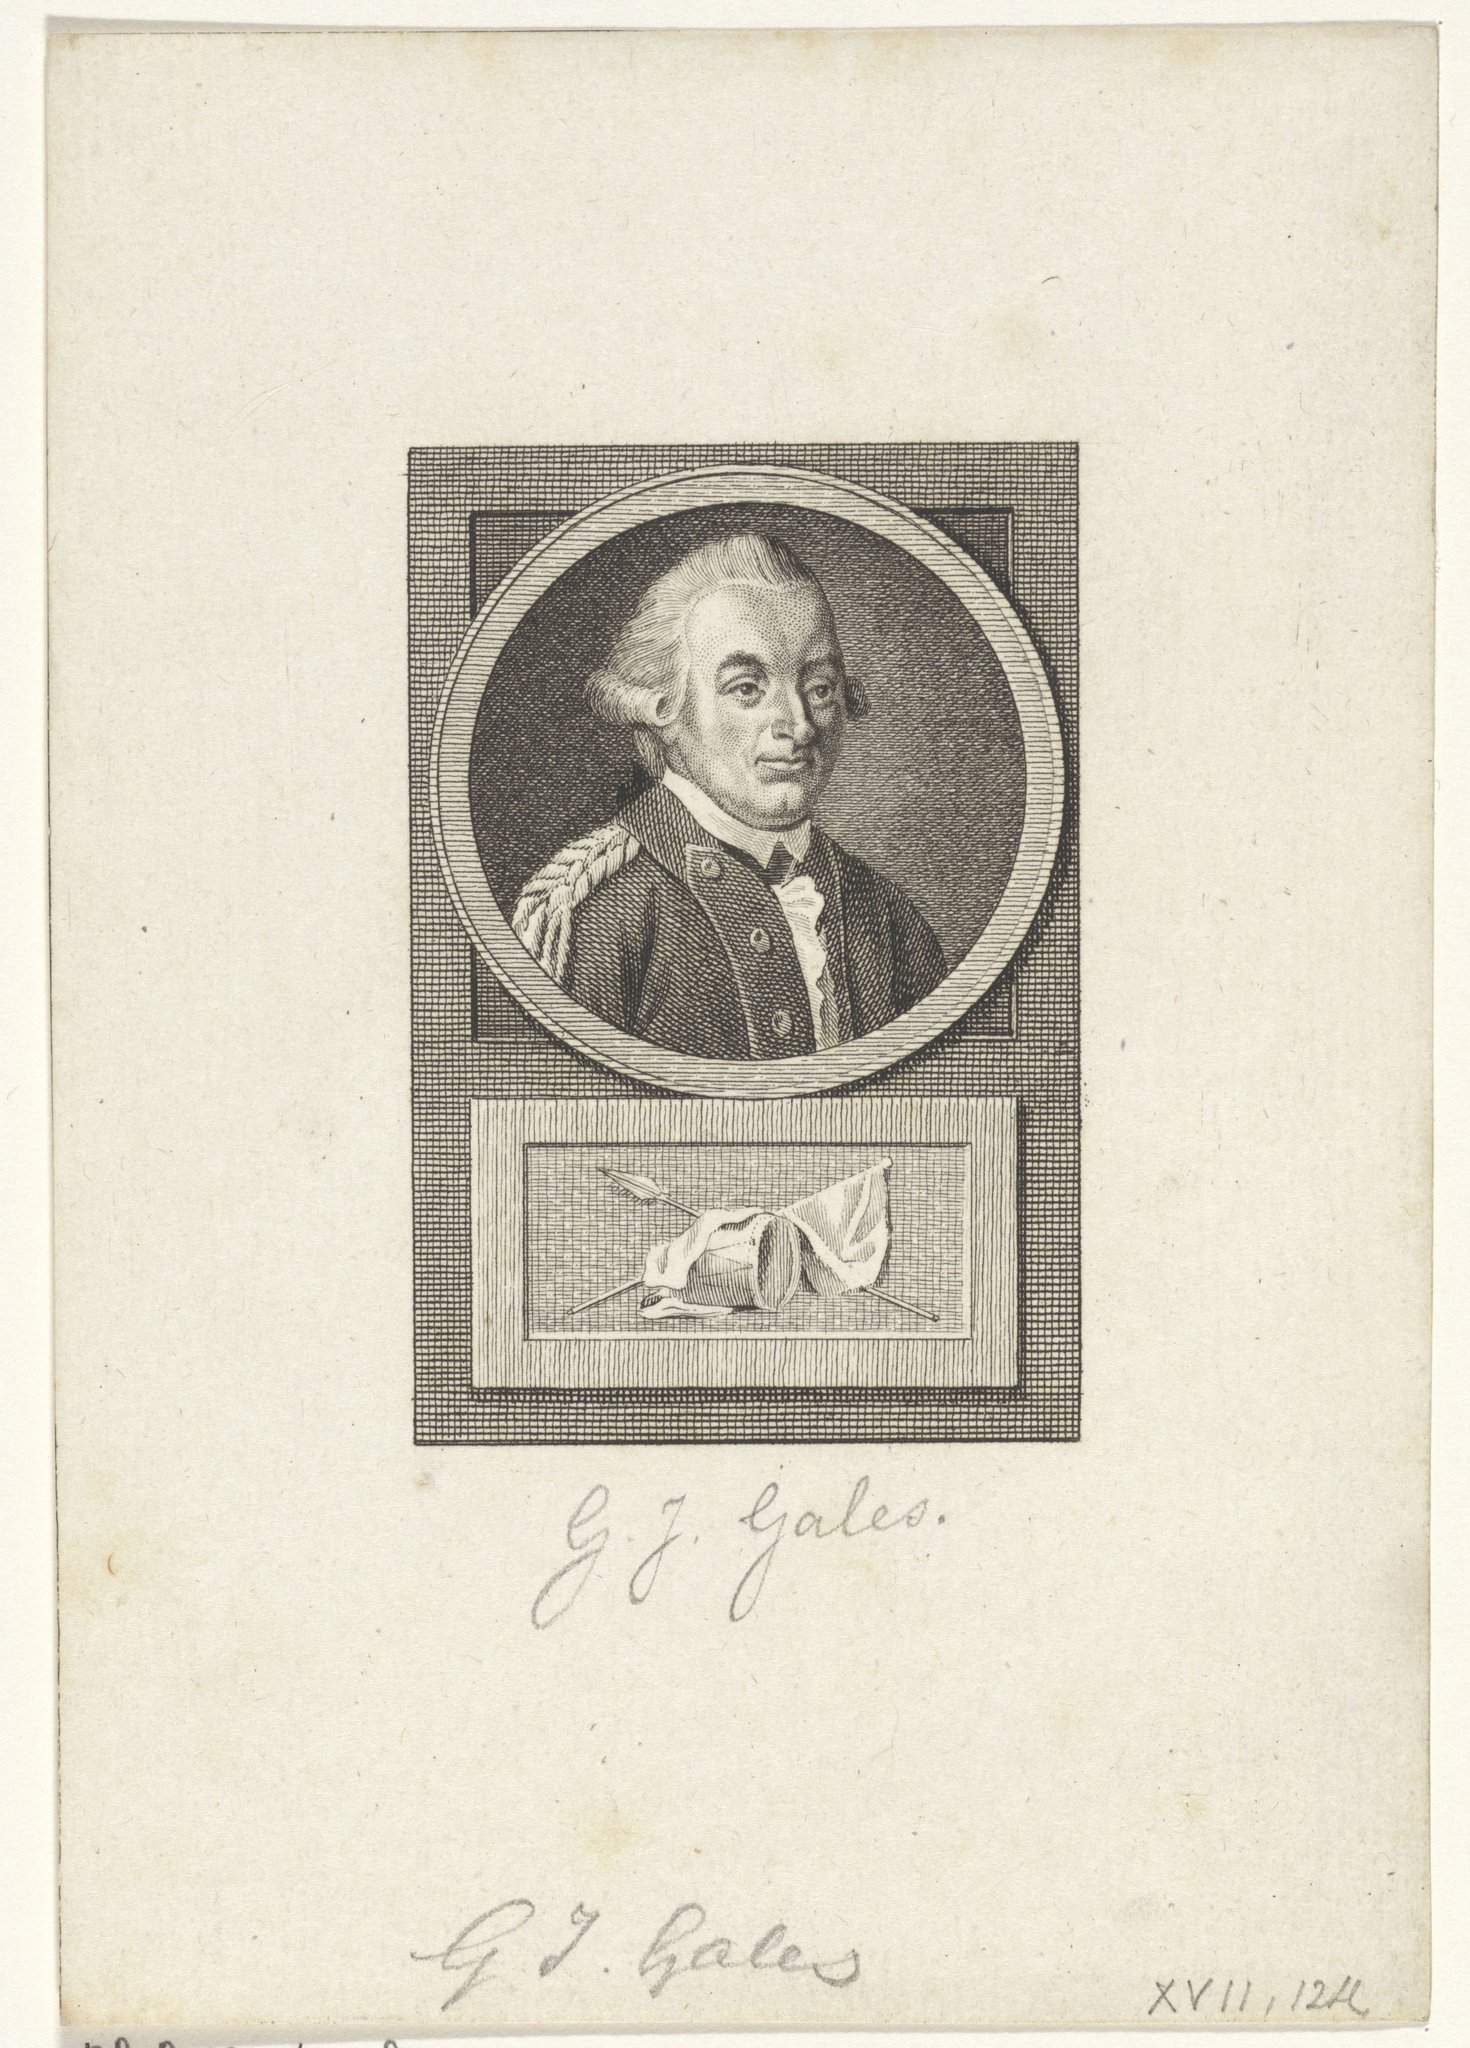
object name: print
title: Portret van Gale Isaac Gales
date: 1783-1795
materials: paper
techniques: engraving, etching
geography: amsterdam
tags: drum (musical instrument), (military) flags and standards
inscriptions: inscription: ‘G.J.Gales/ XVII, 124’, collector's mark: Lugt 2228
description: Latere staat prent gebruikt in: Fokke, Jan. Geschiedenissen der Vereenigde Nederlanden voor de vaderlandsche jeugd Ie-XXVste deel. Amsterdam: Johannes Allart, 1783-1795. Deel XVII.